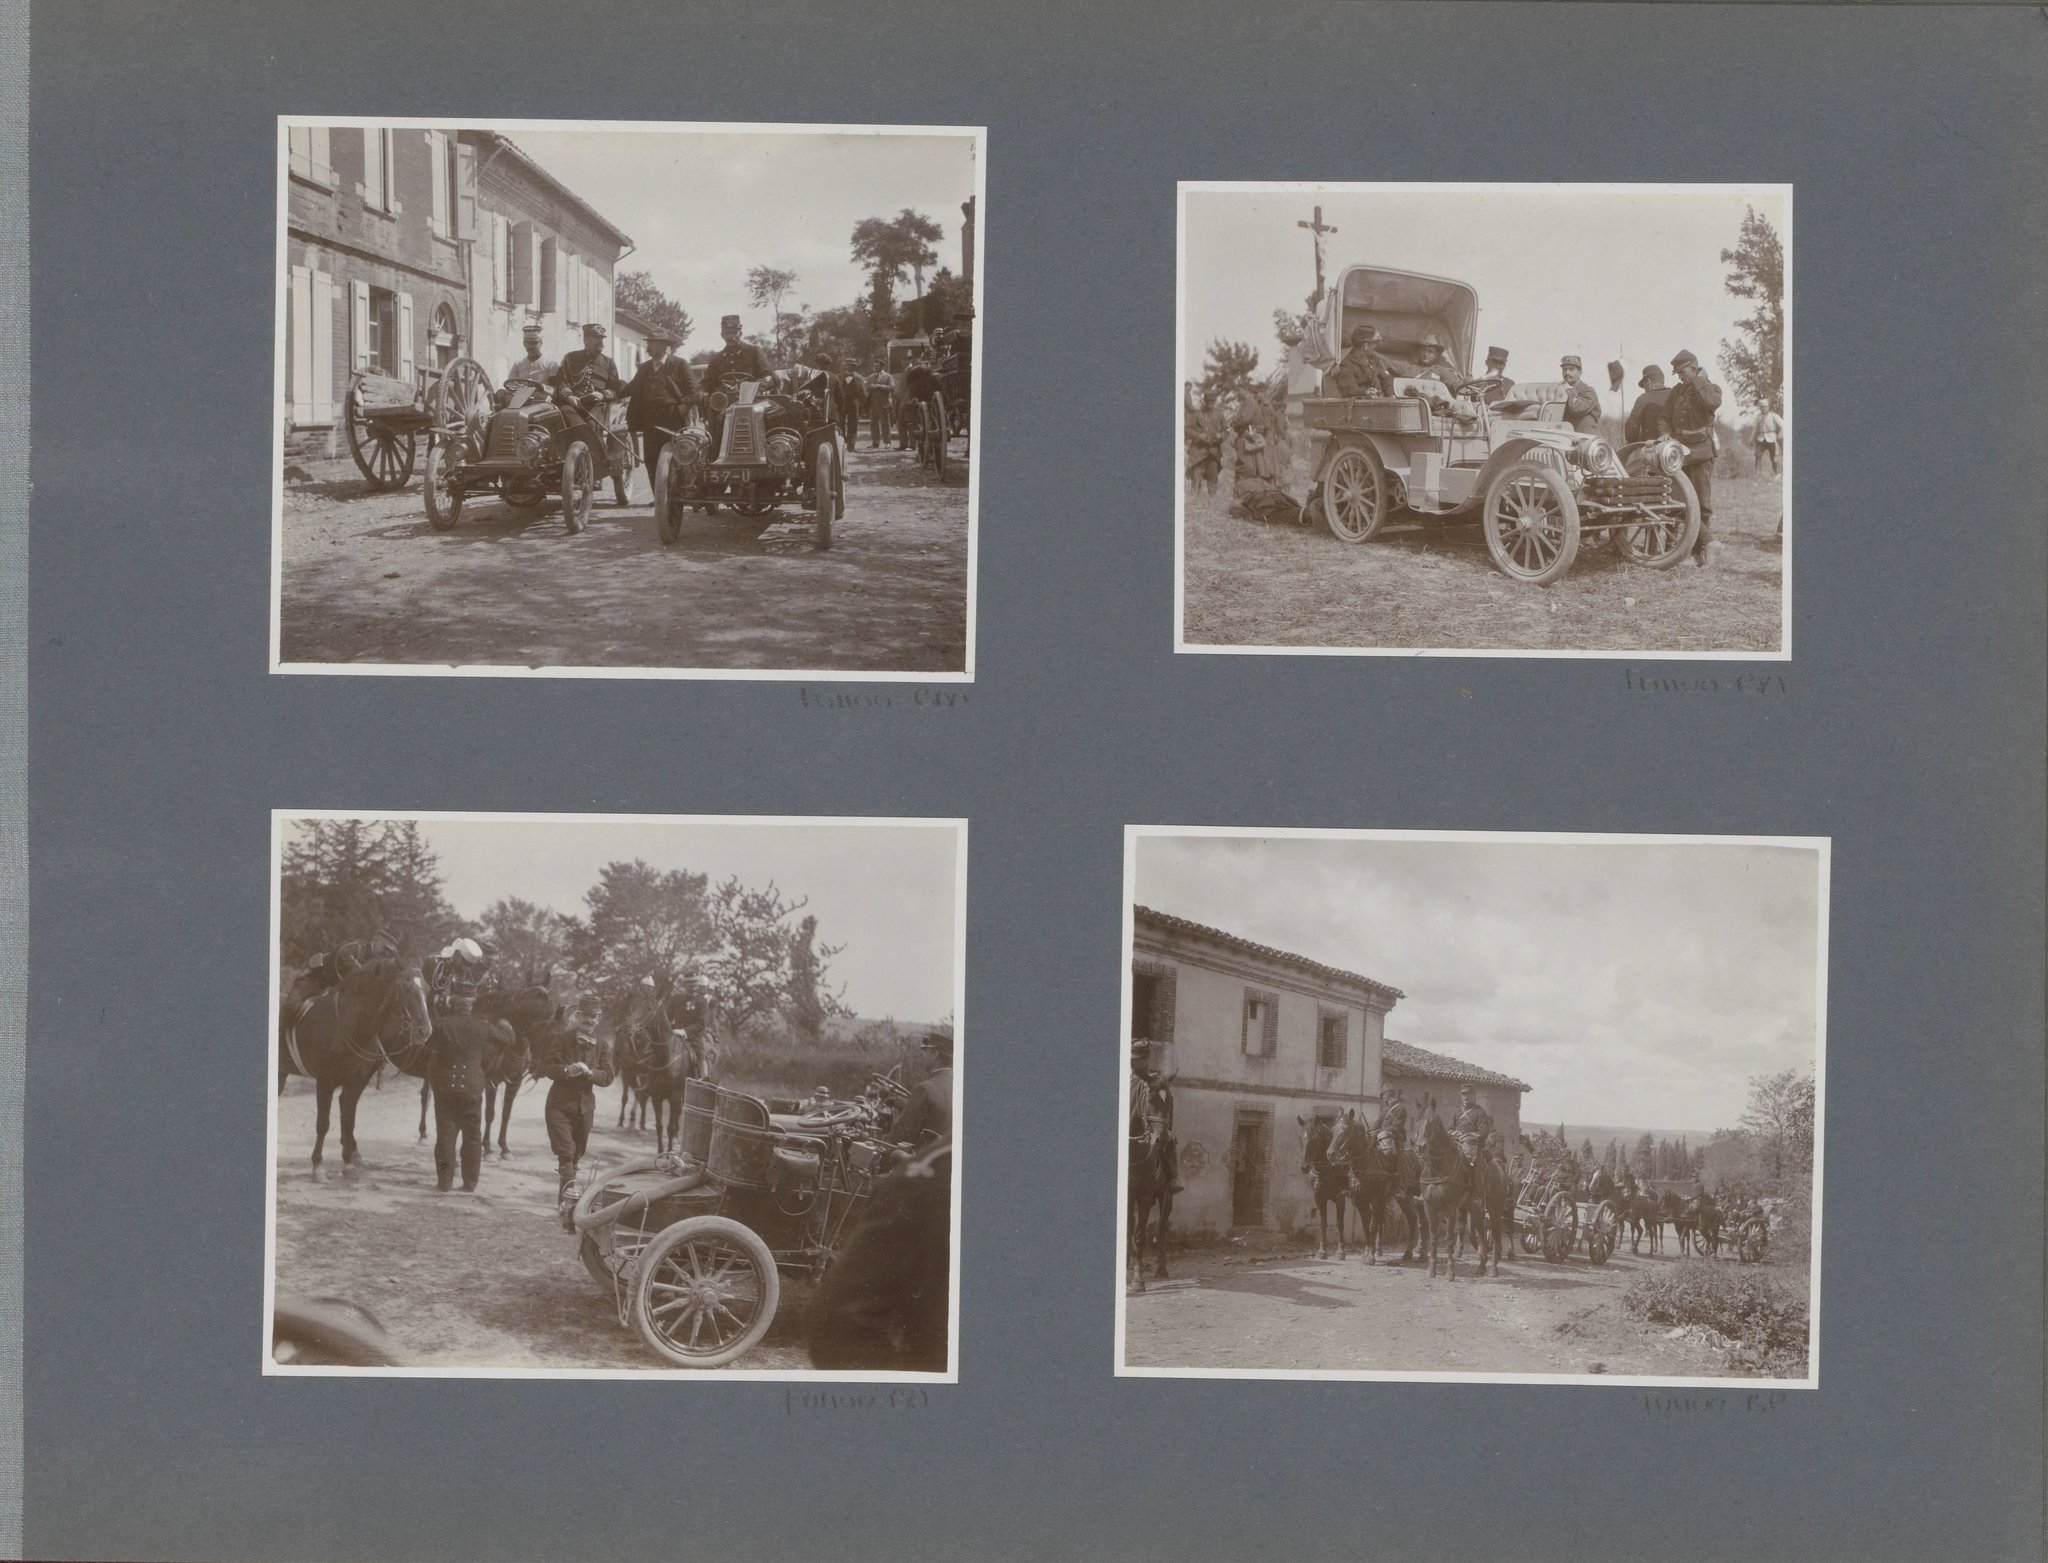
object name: album leaf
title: Cavalerie bij een auto in Frankrijk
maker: Anonymous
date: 1902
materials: paper, photographic support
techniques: daylight paper print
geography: france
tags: land forces (+ cavalry, horsemen), land forces, automobile, france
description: Onderdeel van Fotoalbum van een legeroefening in Zuidwest-Frankrijk in 1902.